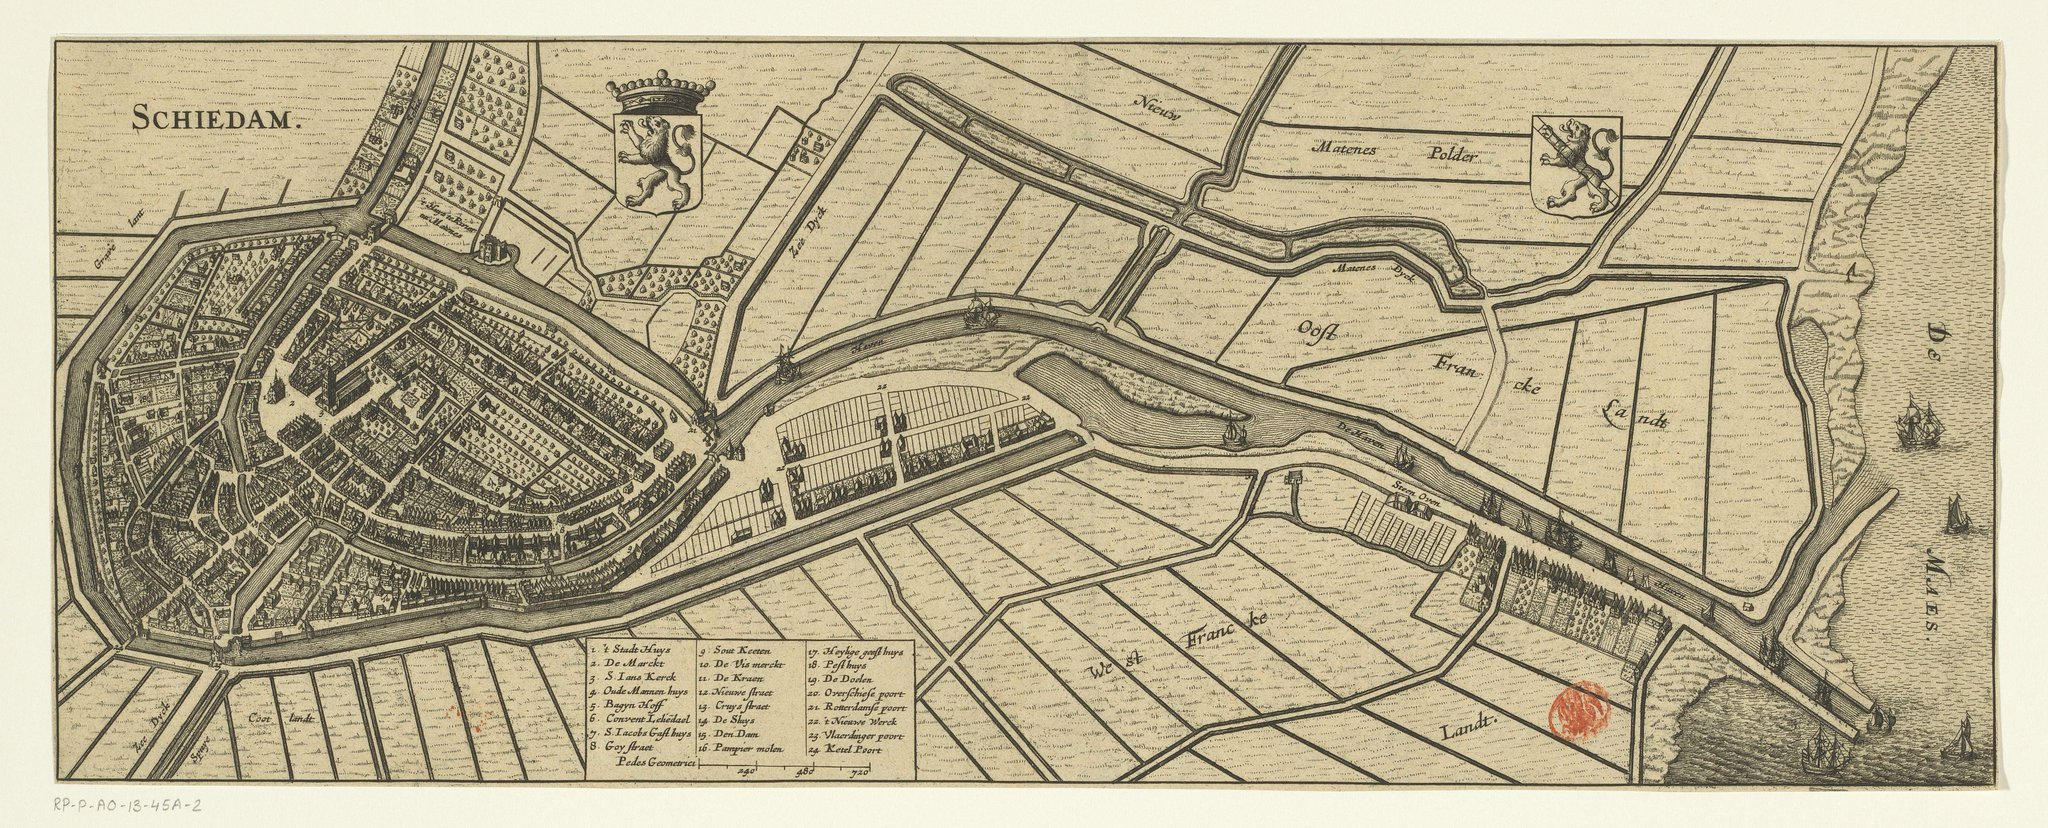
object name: area plan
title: Schiedam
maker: Anonymous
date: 1657-1690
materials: paper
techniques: engraving, etching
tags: coat of arms (as symbol of the state, etc.) (+ city; municipal), maps of cities, coat of arms (as symbol of the state, etc.) (+ province; provincial)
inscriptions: collector's mark: Lugt 195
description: Oorspronkelijk werd deze plattegrond samen met twee andere plattegronden (van Brielle en Gorinchem) gedrukt van één koperplaat. Deze prent is verschenen in: Theatrum Urbium Celebriorum totius Belgii sive Germaniae Inferioris. 2 delen. Amsterdam: Johannes Janssonius, 1657, dl. 2. En in: Tooneel der vermaarste koop-steden en handelsplaatsen van de geheele wereld. 2 delen. Amsterdam: erven Johannes Janssonius van Waesberge (I) / Johannes Janssonius van Waesberge (II), 1682, dl. 1. De plaat is daarna versneden tot drie platen zodat de plattegronden apart van elkaar gedrukt konden worden. In deze vorm komen de drie plattegronden ook voor in: Leti, Gregorio. Teatro Belgico o vero ritratti historici, chronologici, politici e geografici delle Sette Provincie Unite. 2 delen. Amsterdam: Willem de Jonge, 1690, dl. 2. Het huidige exemplaar is dusdanig binnen de plaatrand afgesneden dat niet na te gaan is of het van de niet of wel versneden plaat afkomstig is. Voor de plattegrond van Brielle zie RP-P-AO-13-56C. Voor de plattegrond van Gorinchem zie RP-P-AO-14-15B.